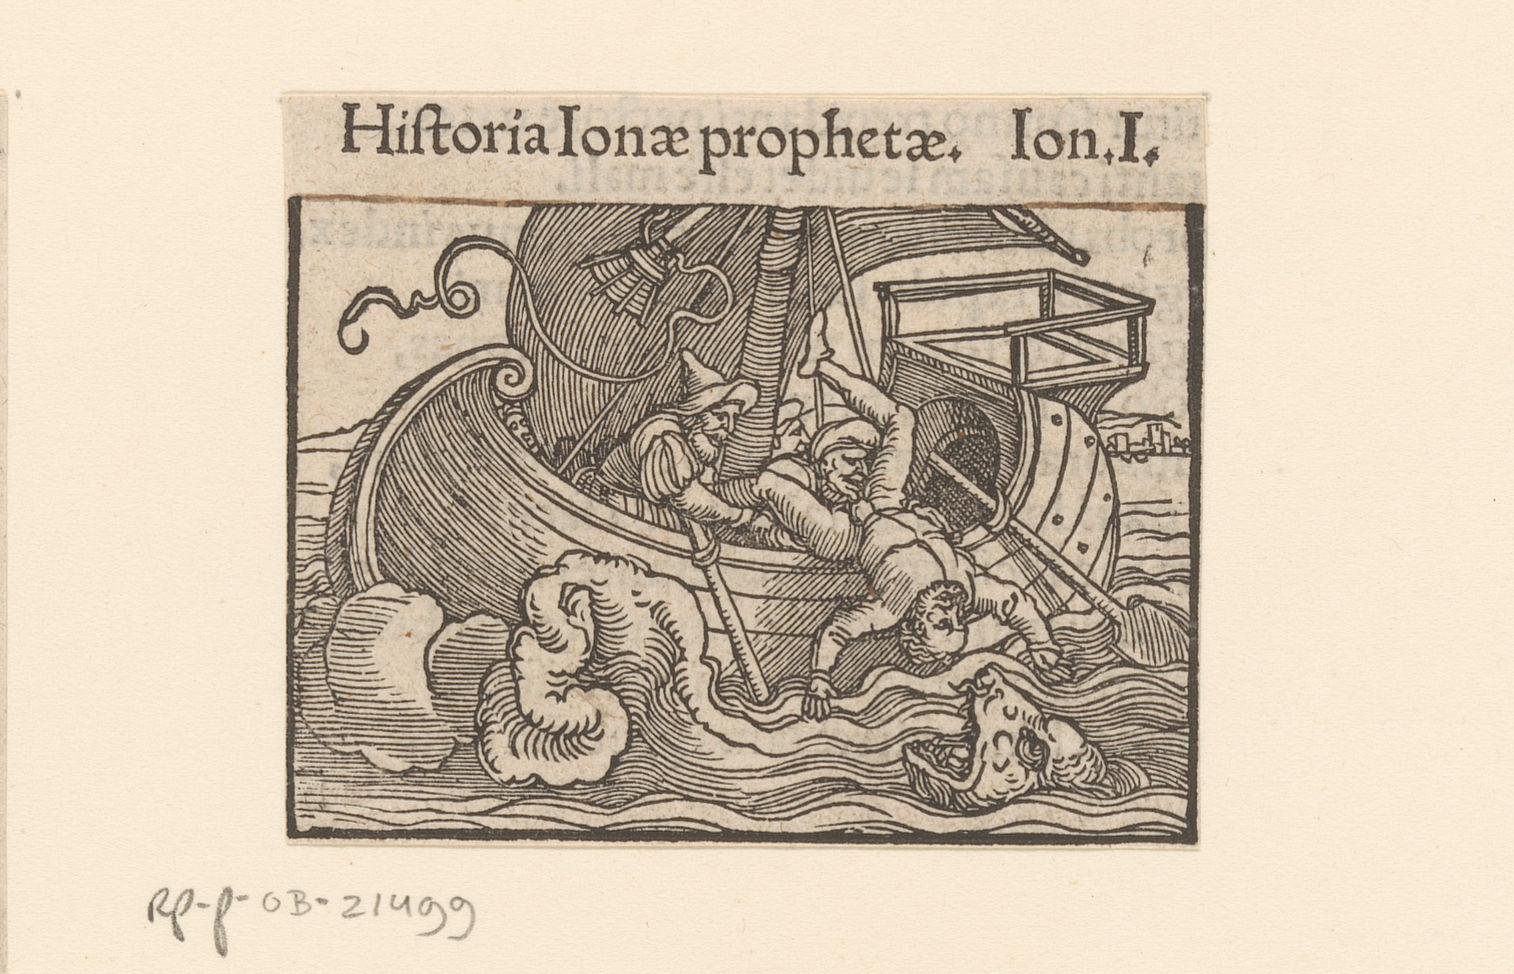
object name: print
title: Jona wordt overboord gegooid in de mond van de walvis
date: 1530-1533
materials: paper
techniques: woodcut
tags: the sailors reluctantly throw the prophet jonah into the sea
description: Prent afkomstig uit: Biblicae historiae. Frankfurt am Main: Egenloph, 1539.